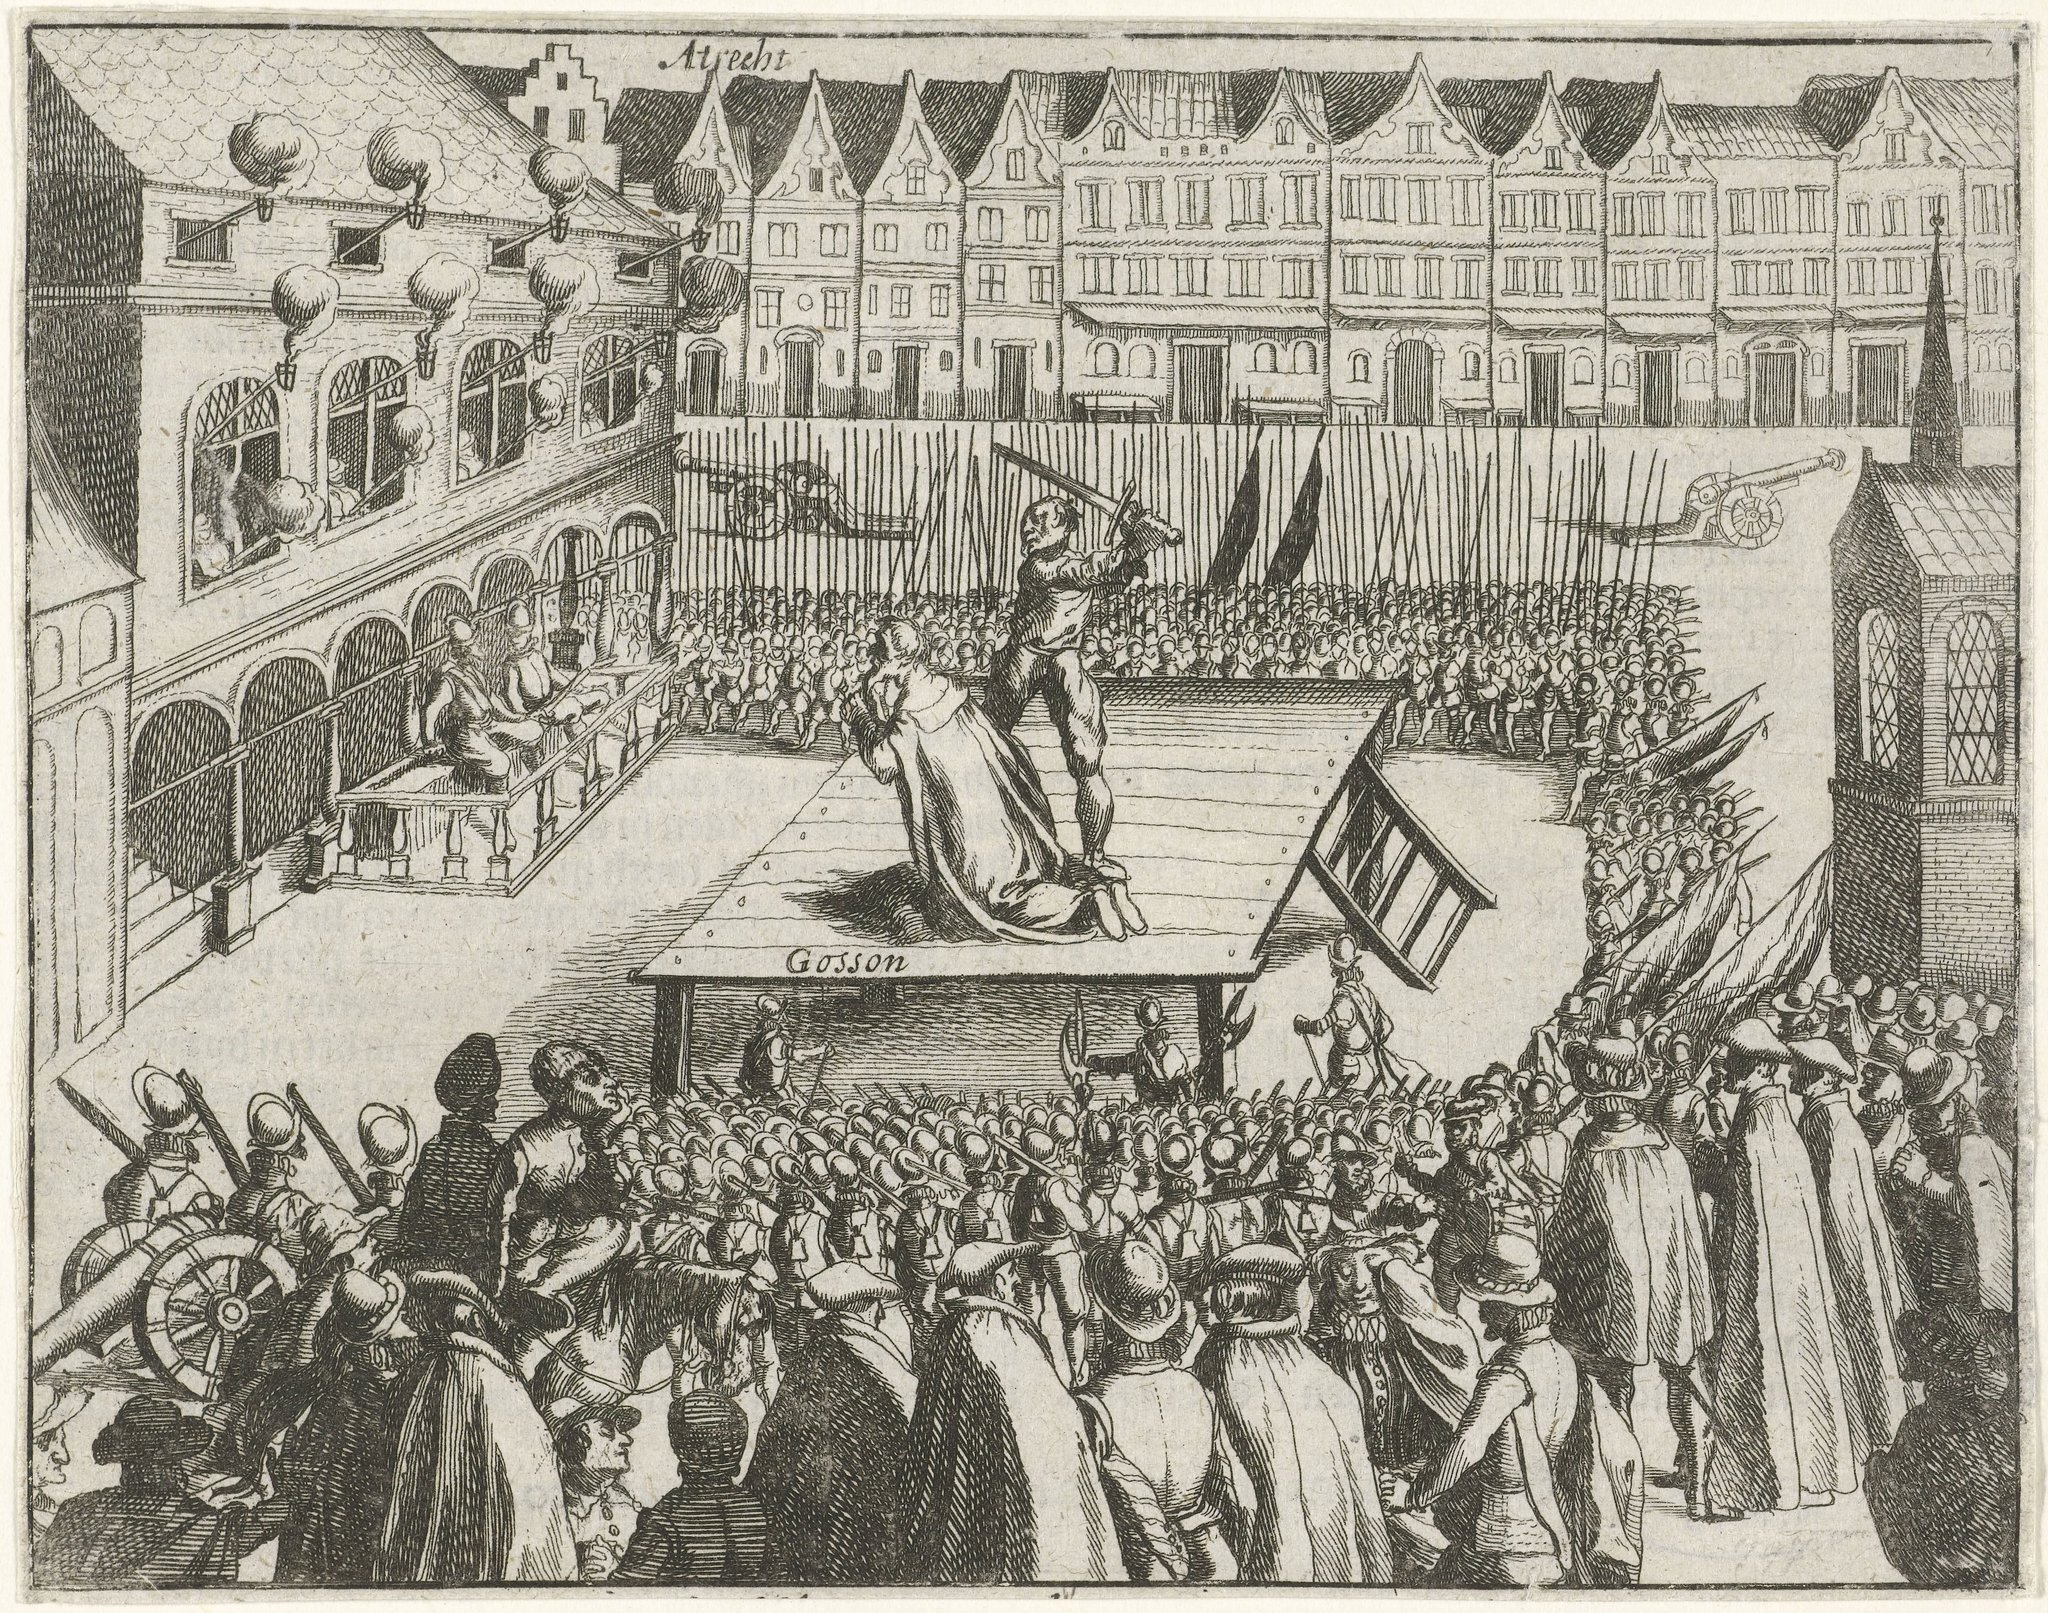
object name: print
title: Onthoofding van Gosson te Atrecht, 1578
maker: simon frisius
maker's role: print maker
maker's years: 1570-1628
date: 1613-1615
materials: paper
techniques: etching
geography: northern netherlands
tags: on the scaffold or place of execution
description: Onthoofding van de raadsheer Nicolas Gosson te Atrecht, wegens sympathie met de Malcontenten, 26 oktober 1578. Gosson knielt op het schavot op een plein. Bedrukt op achterzijde met tekst in het Nederlands.